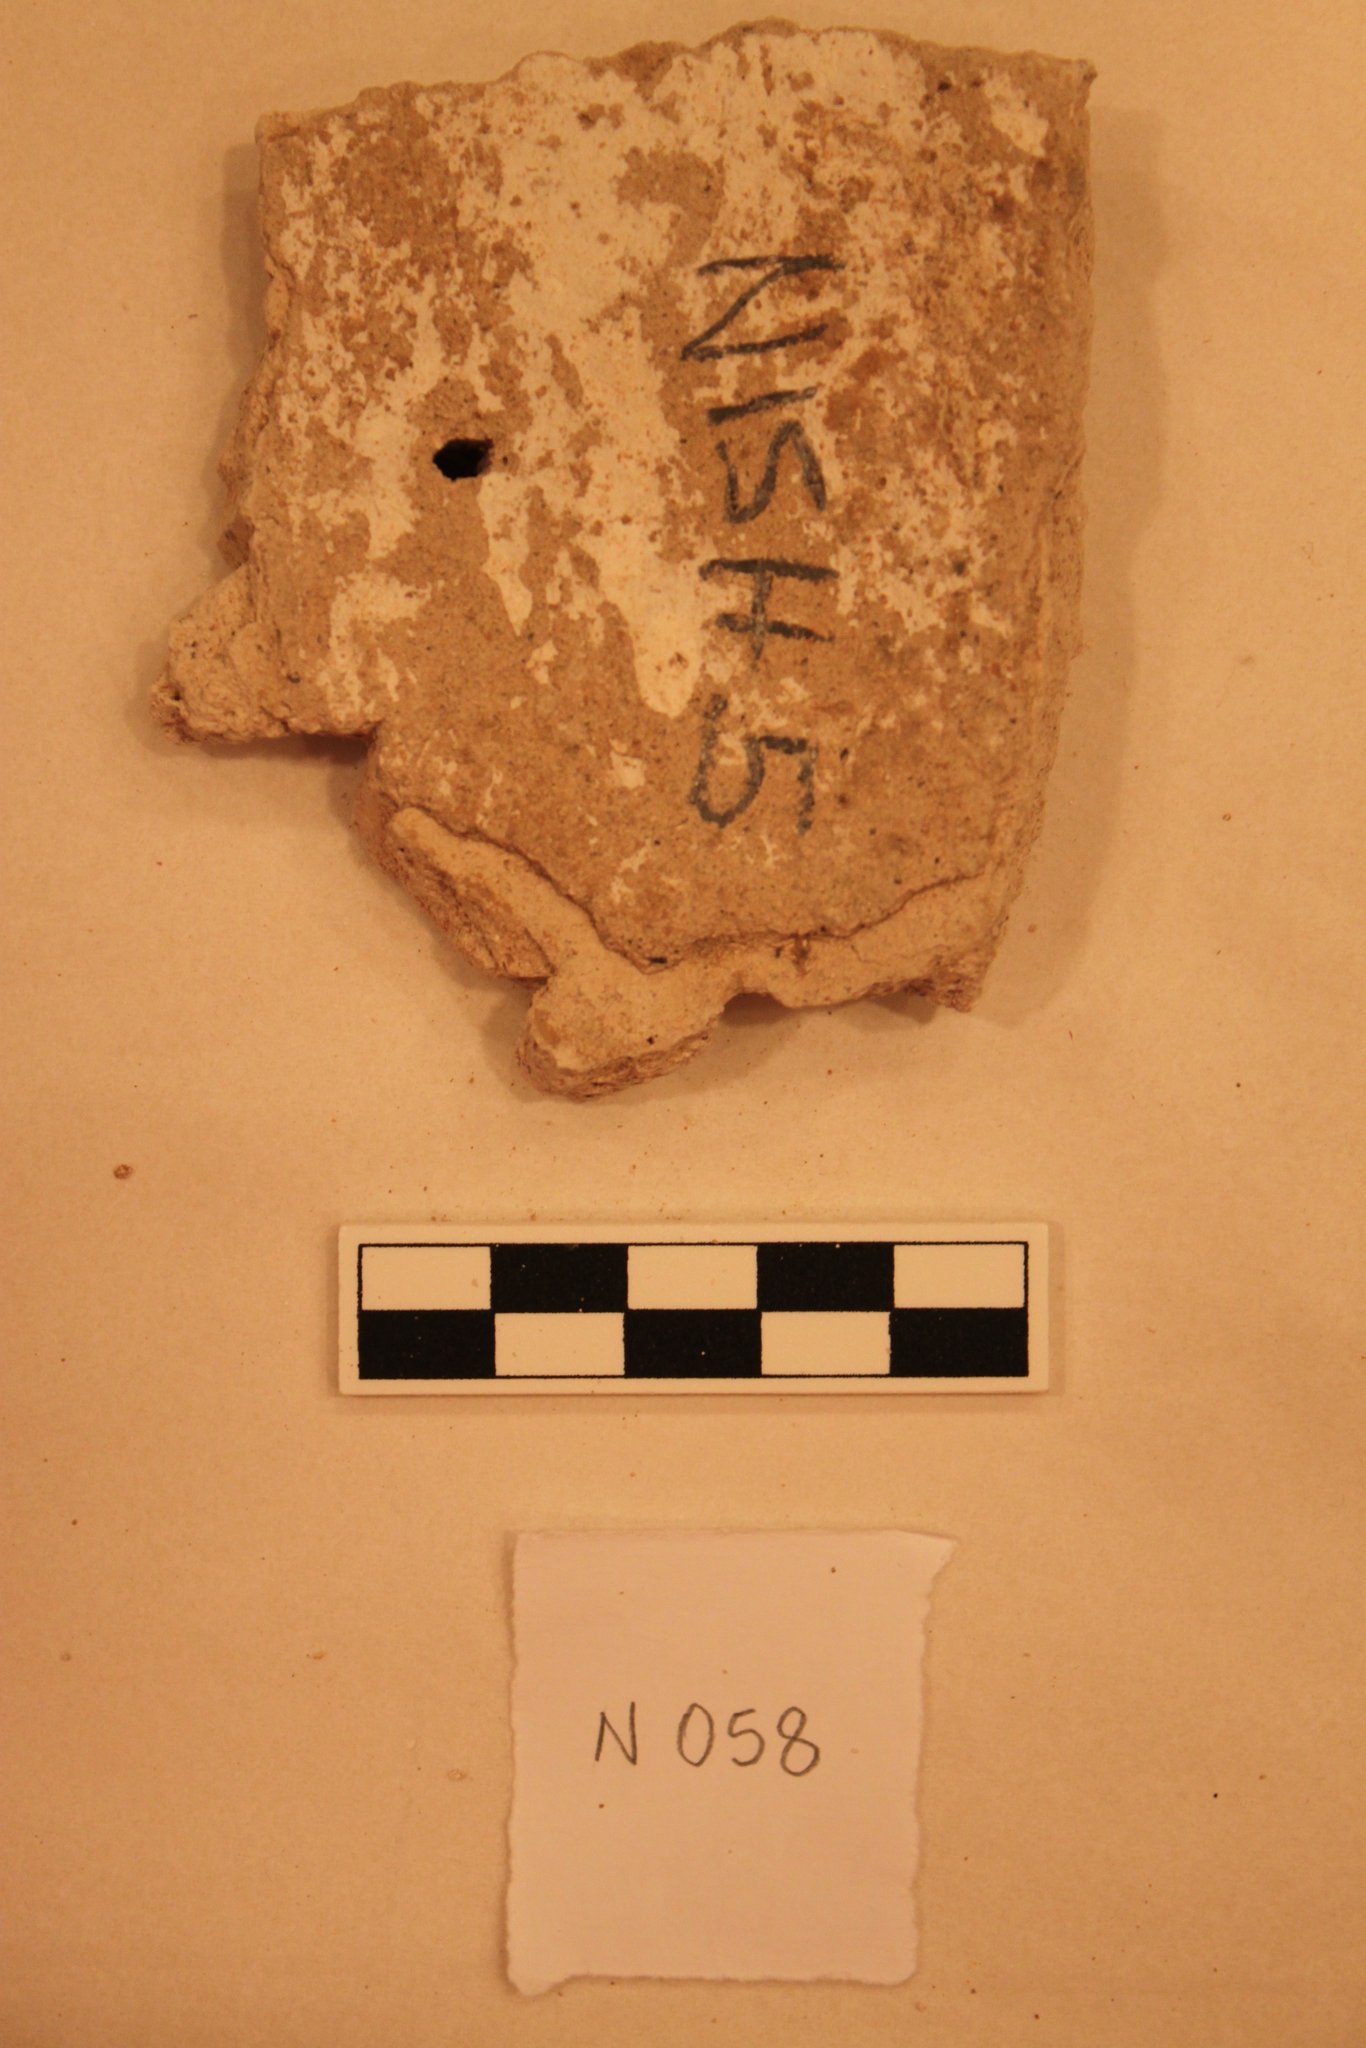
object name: fragment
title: Stucco Fragment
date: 701-1200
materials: plaster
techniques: carving, painting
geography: iran